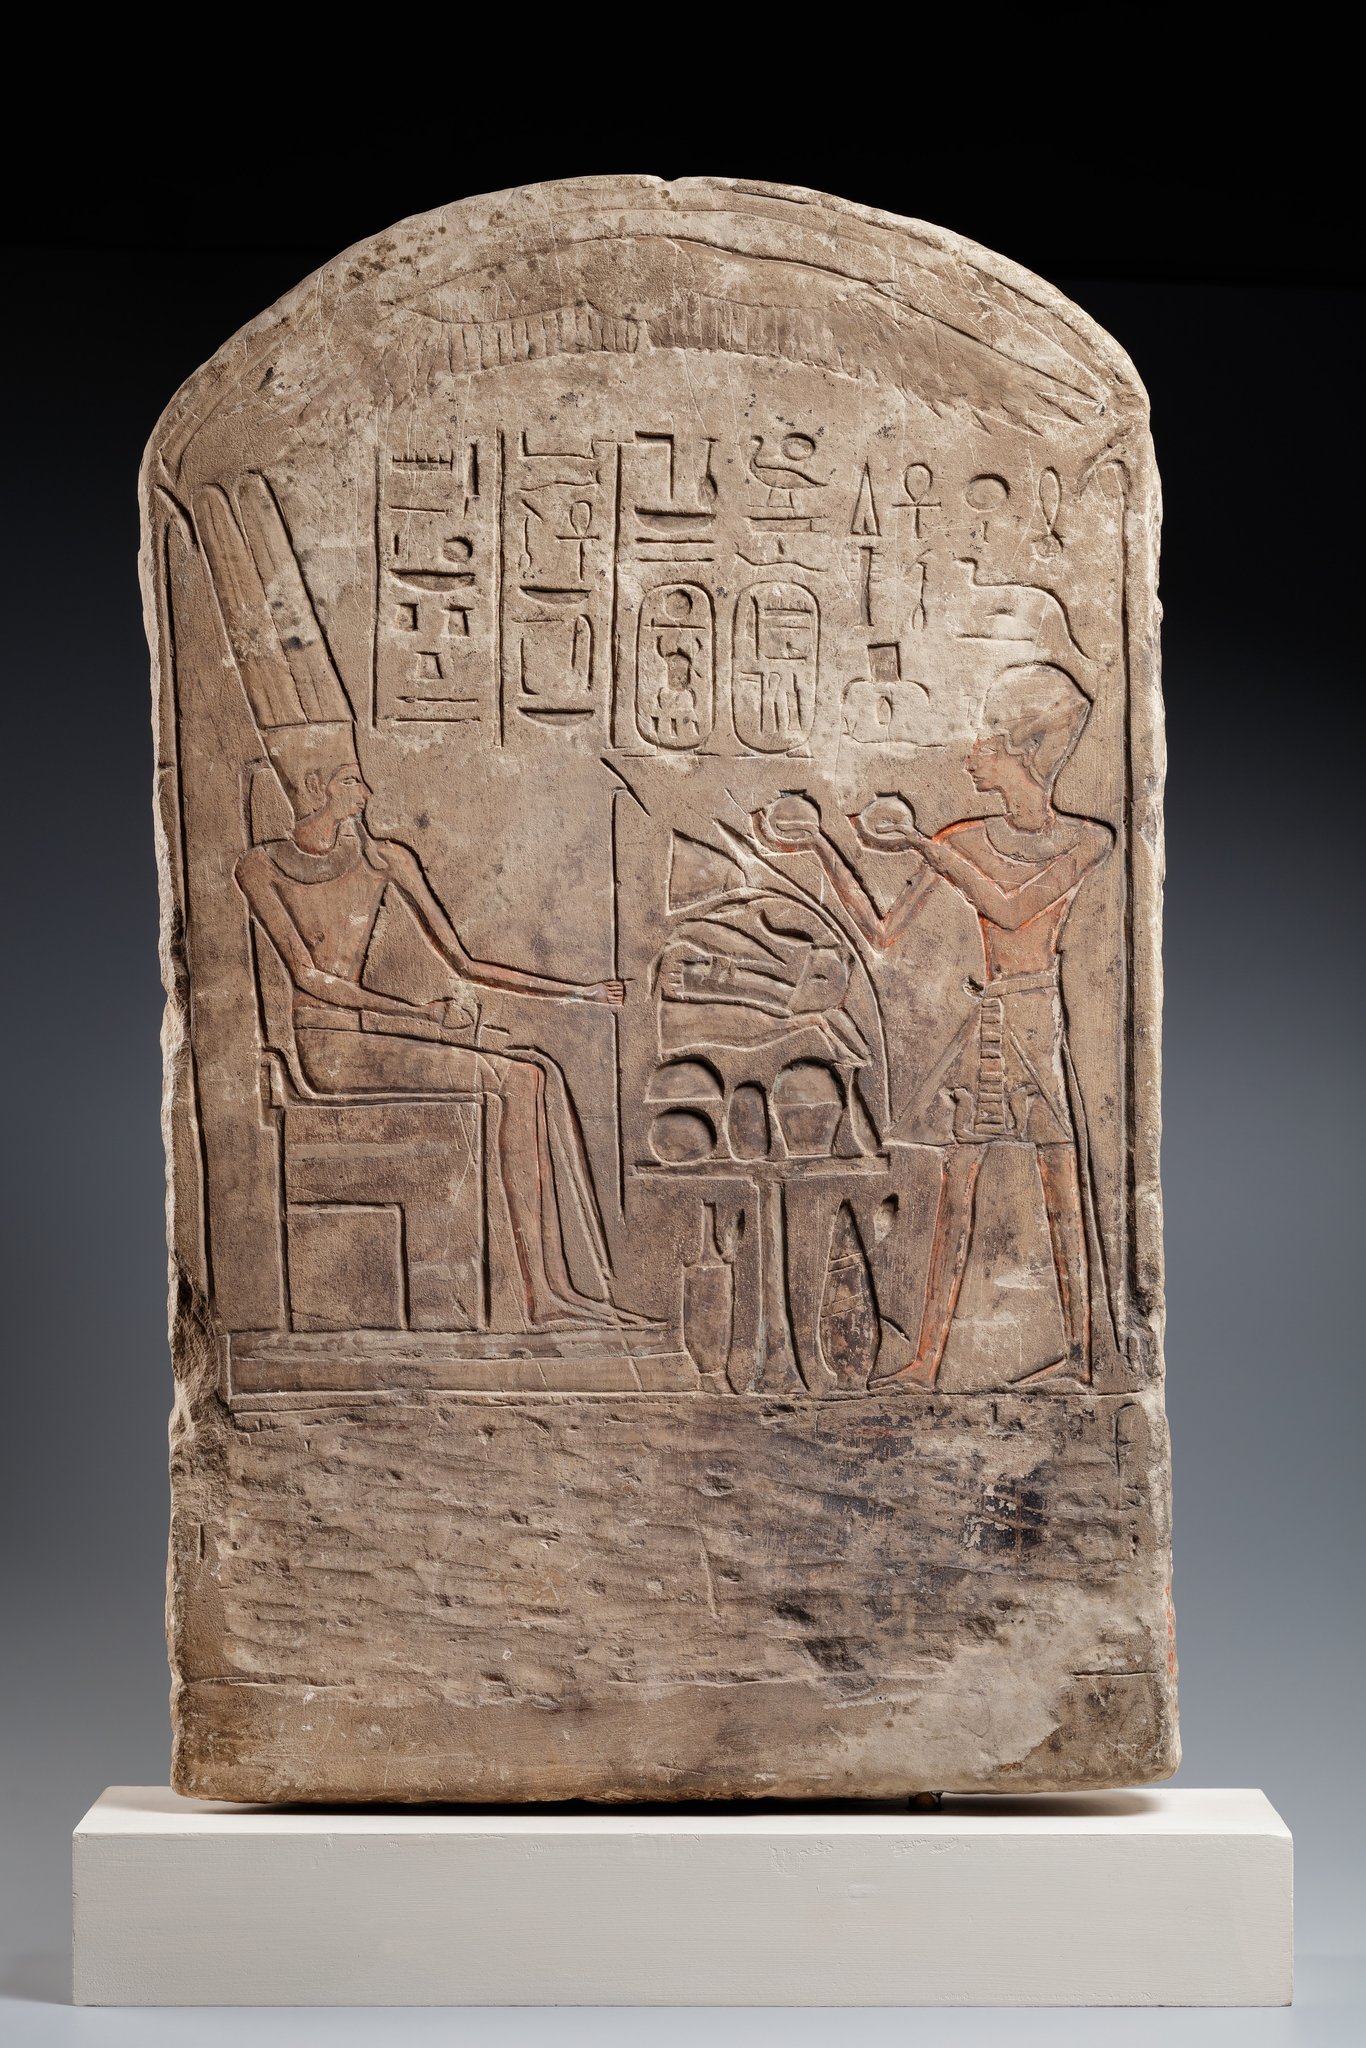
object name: stela, amenhotep ii, amun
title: Stela of Amenhotep II Offering to Amun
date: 1427-1400 BCE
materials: limestone, pigment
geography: upper egypt, thebes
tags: men,amun